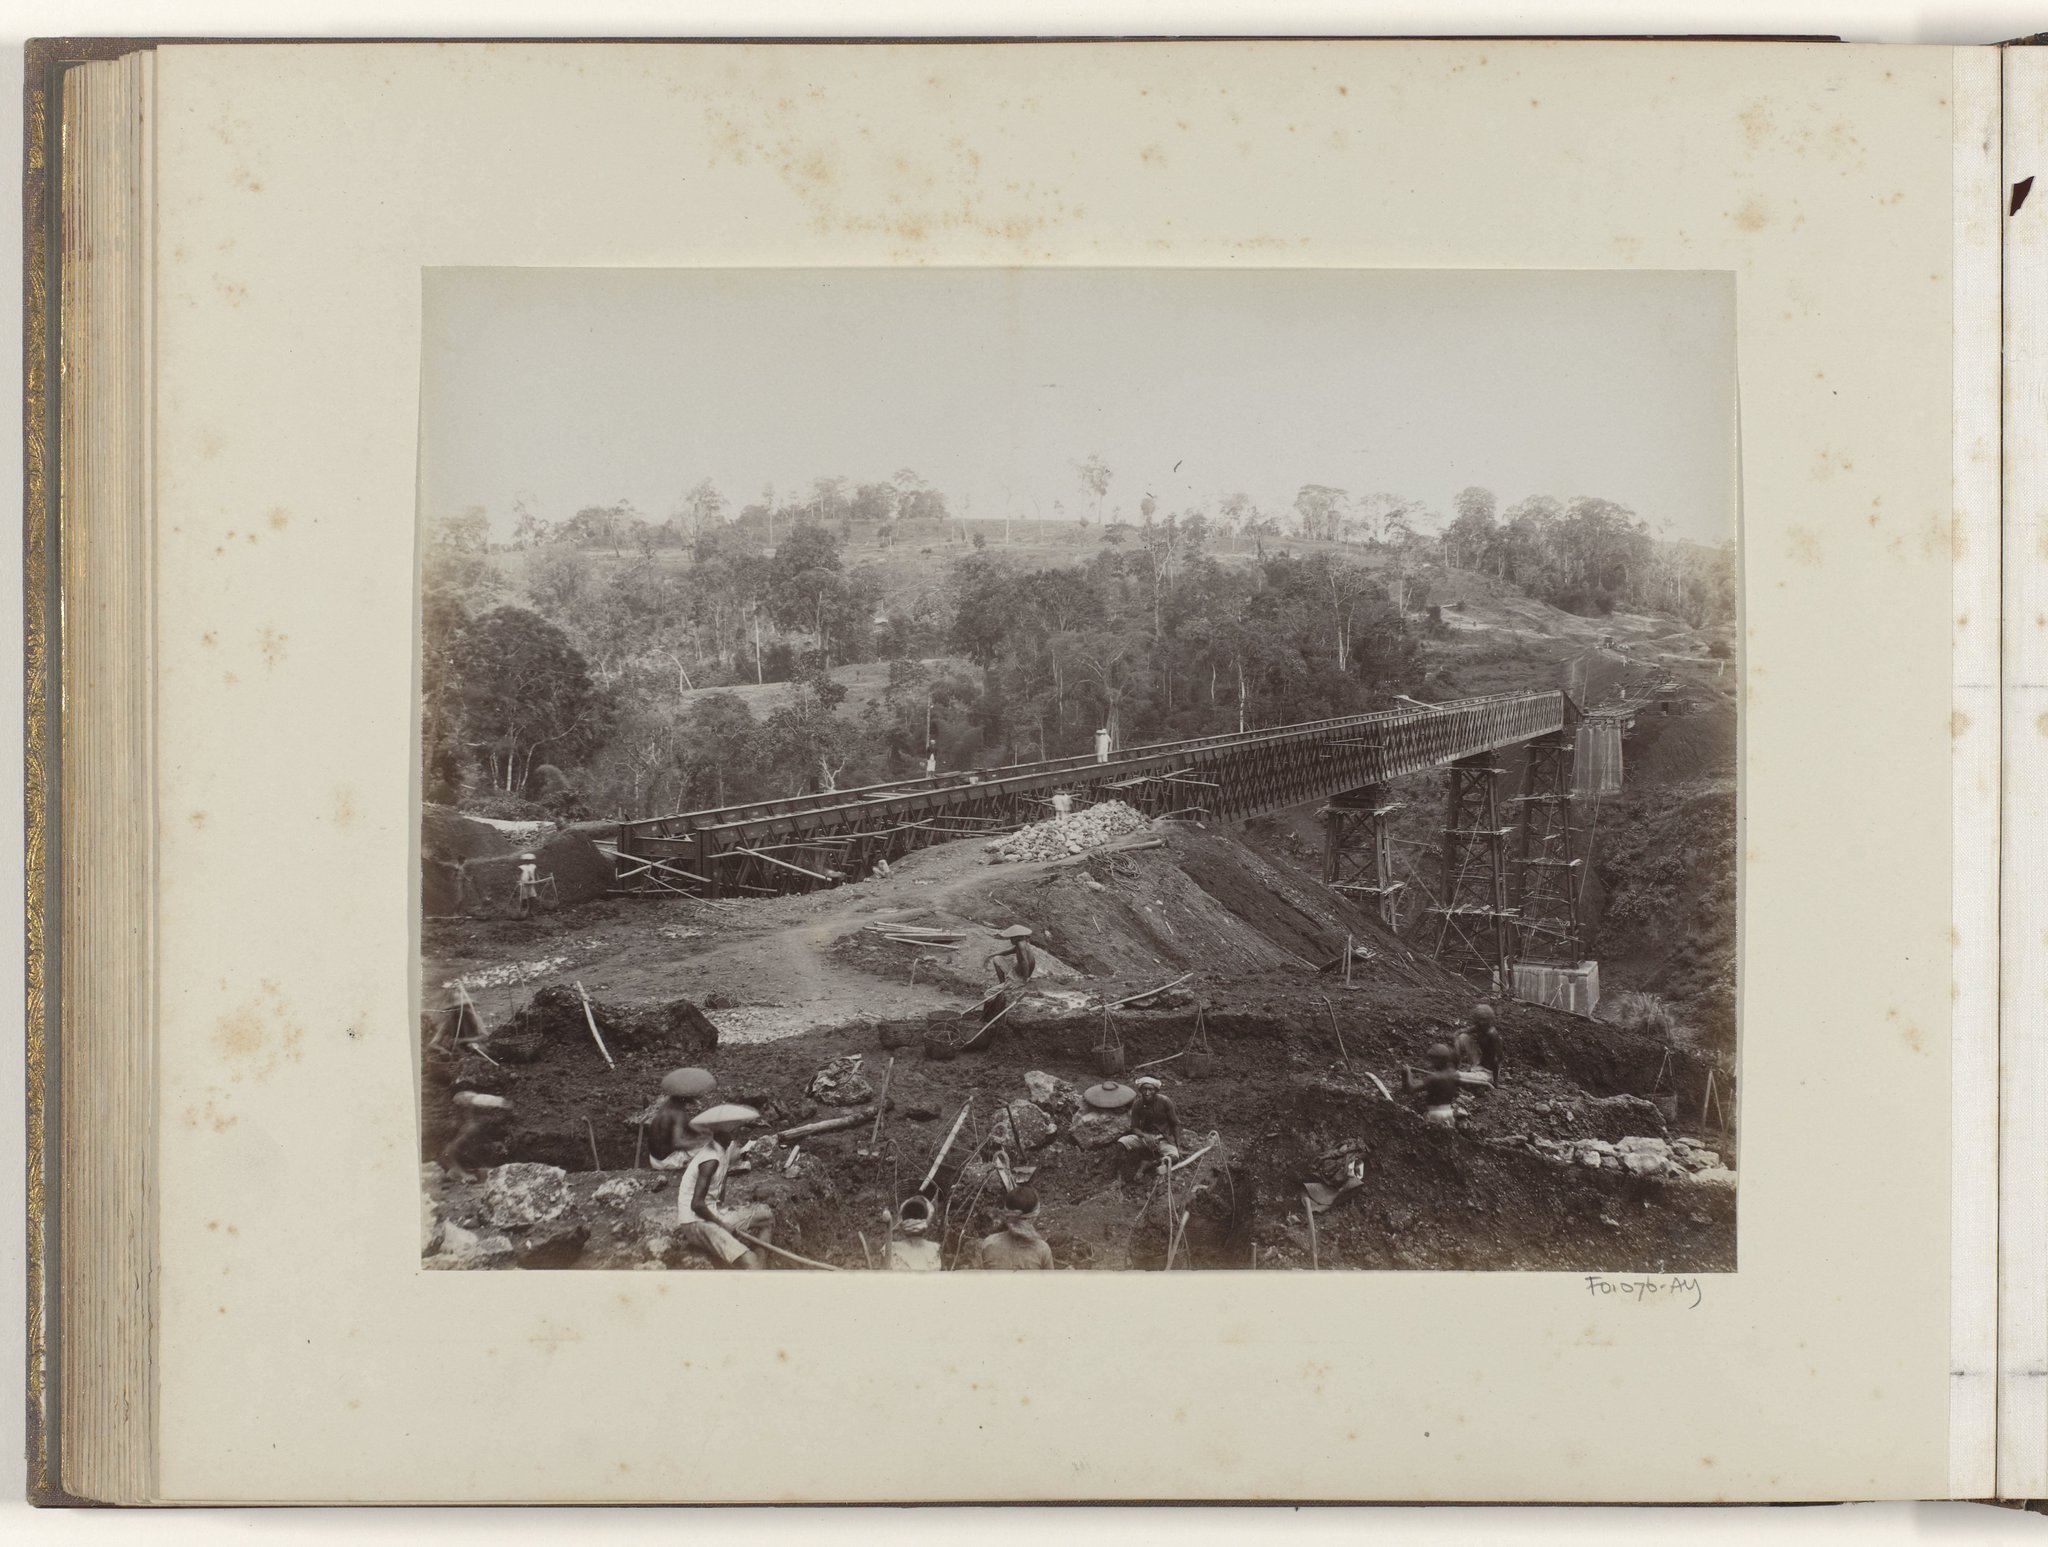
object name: album leaf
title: Aanleg van een spoorbrug in Nederlands-Indië, mogelijk op het traject Djoeja-Magelang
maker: Anonymous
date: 1880-1910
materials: cardboard, paper, photographic support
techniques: albumen print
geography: dutch east indies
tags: landscape with bridge, viaduct or aqueduct, railway, train, dutch east indies, the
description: Onderdeel van Album met foto's van spoorwegen in Nederlands-Indië en prentbriefkaarten.